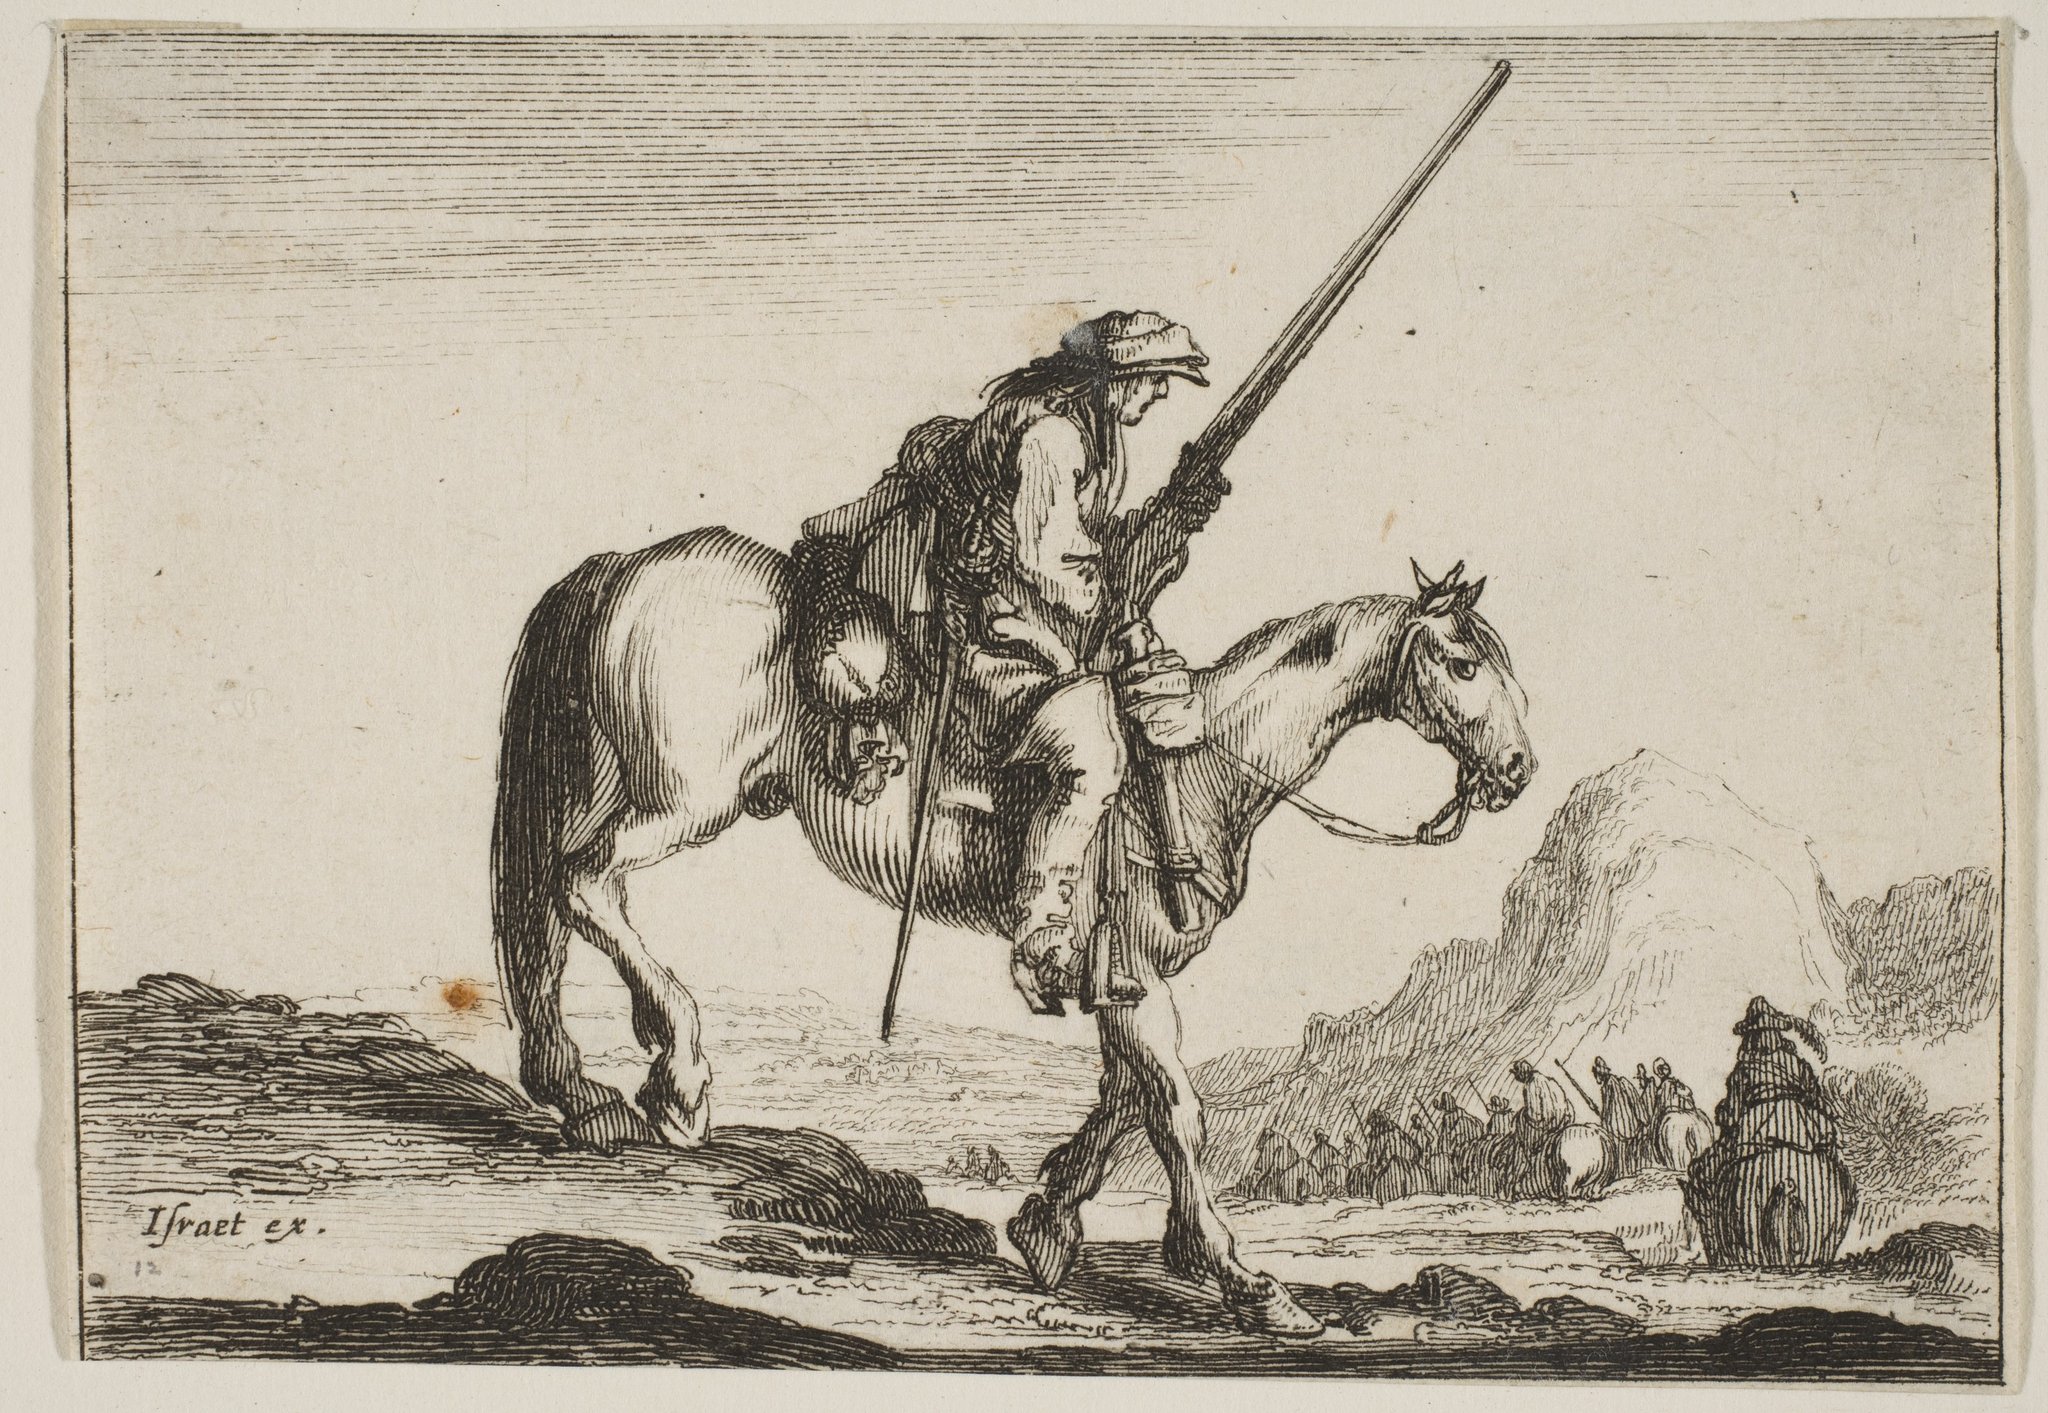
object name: print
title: A soldier on horseback, holding a musket in his right hand, in profile descending a slope towards the right, other soldiers on horseback to right in the background, plate 12 from "Various Figures" (Agréable diversité de figures)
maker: stefano della bella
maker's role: artist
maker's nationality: italian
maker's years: 1610-1664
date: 1642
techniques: engraving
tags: soldiers,firearms,men,horses